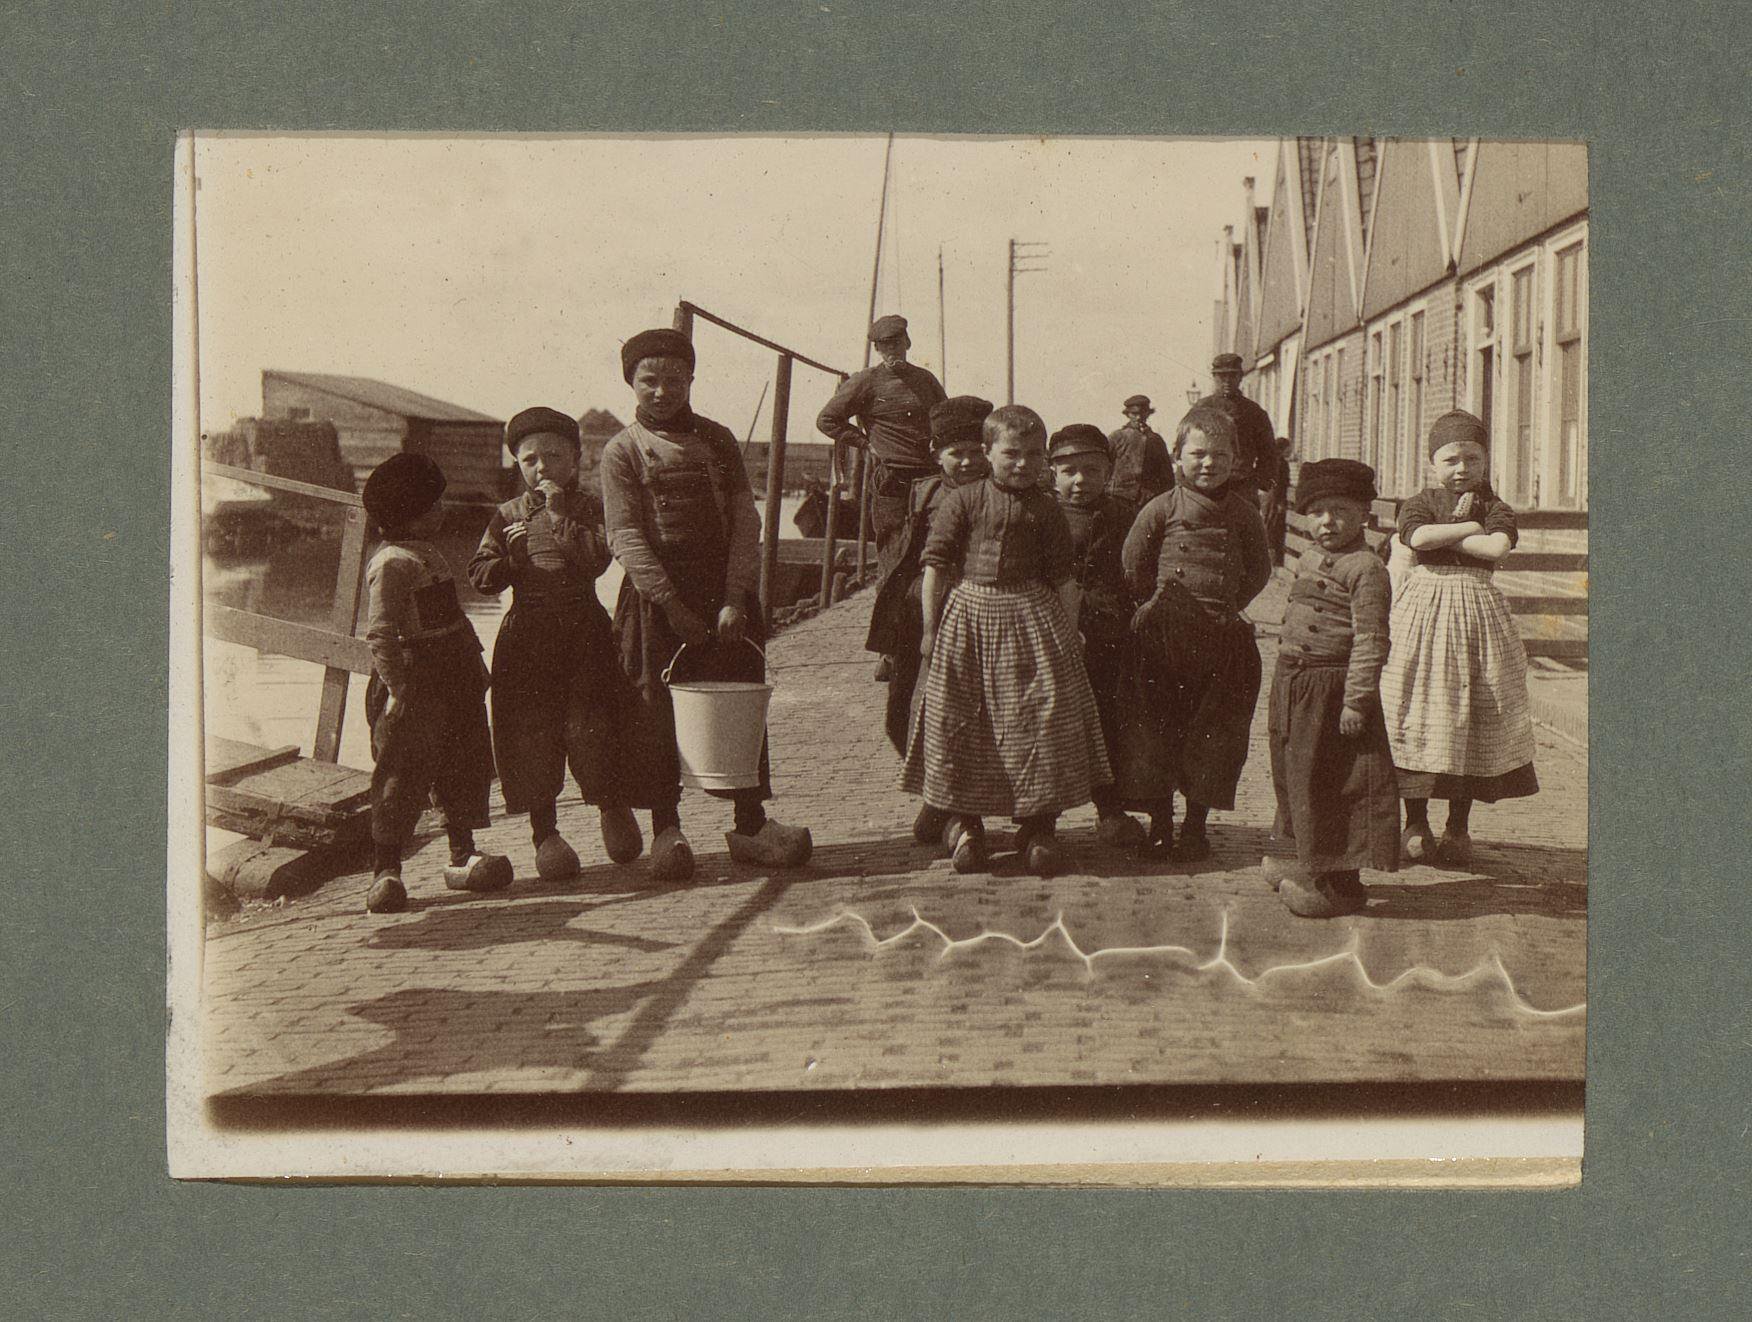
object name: album leaf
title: Groep kinderen in klederdracht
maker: george hidderley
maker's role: fotograaf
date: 1920-1940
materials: photographic support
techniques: gelatin silver print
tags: child, anonymous historical person portrayed, folk costume, regional costume